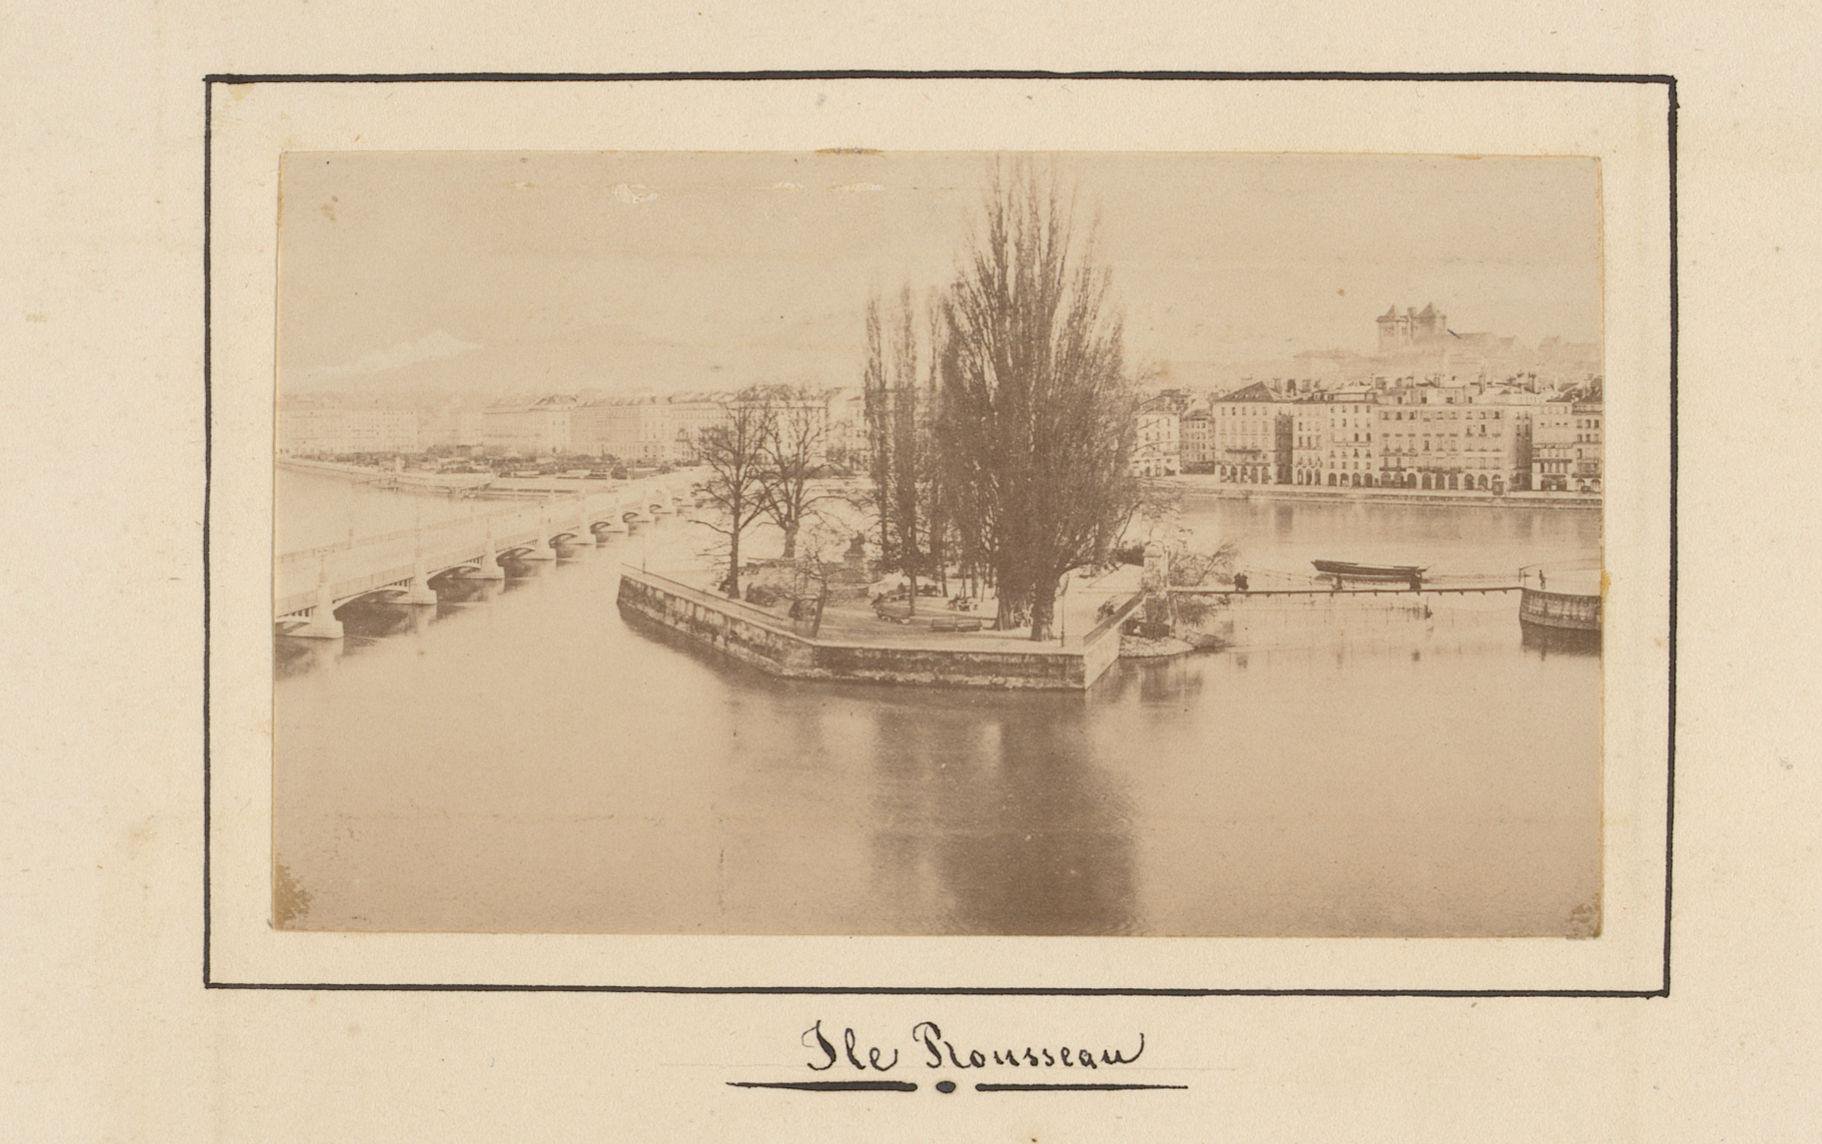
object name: album leaf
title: Île Rousseau te Genève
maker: auguste garcin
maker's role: fotograaf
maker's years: 1816-1895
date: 1870-1890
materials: paper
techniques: albumen print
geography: geneva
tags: island